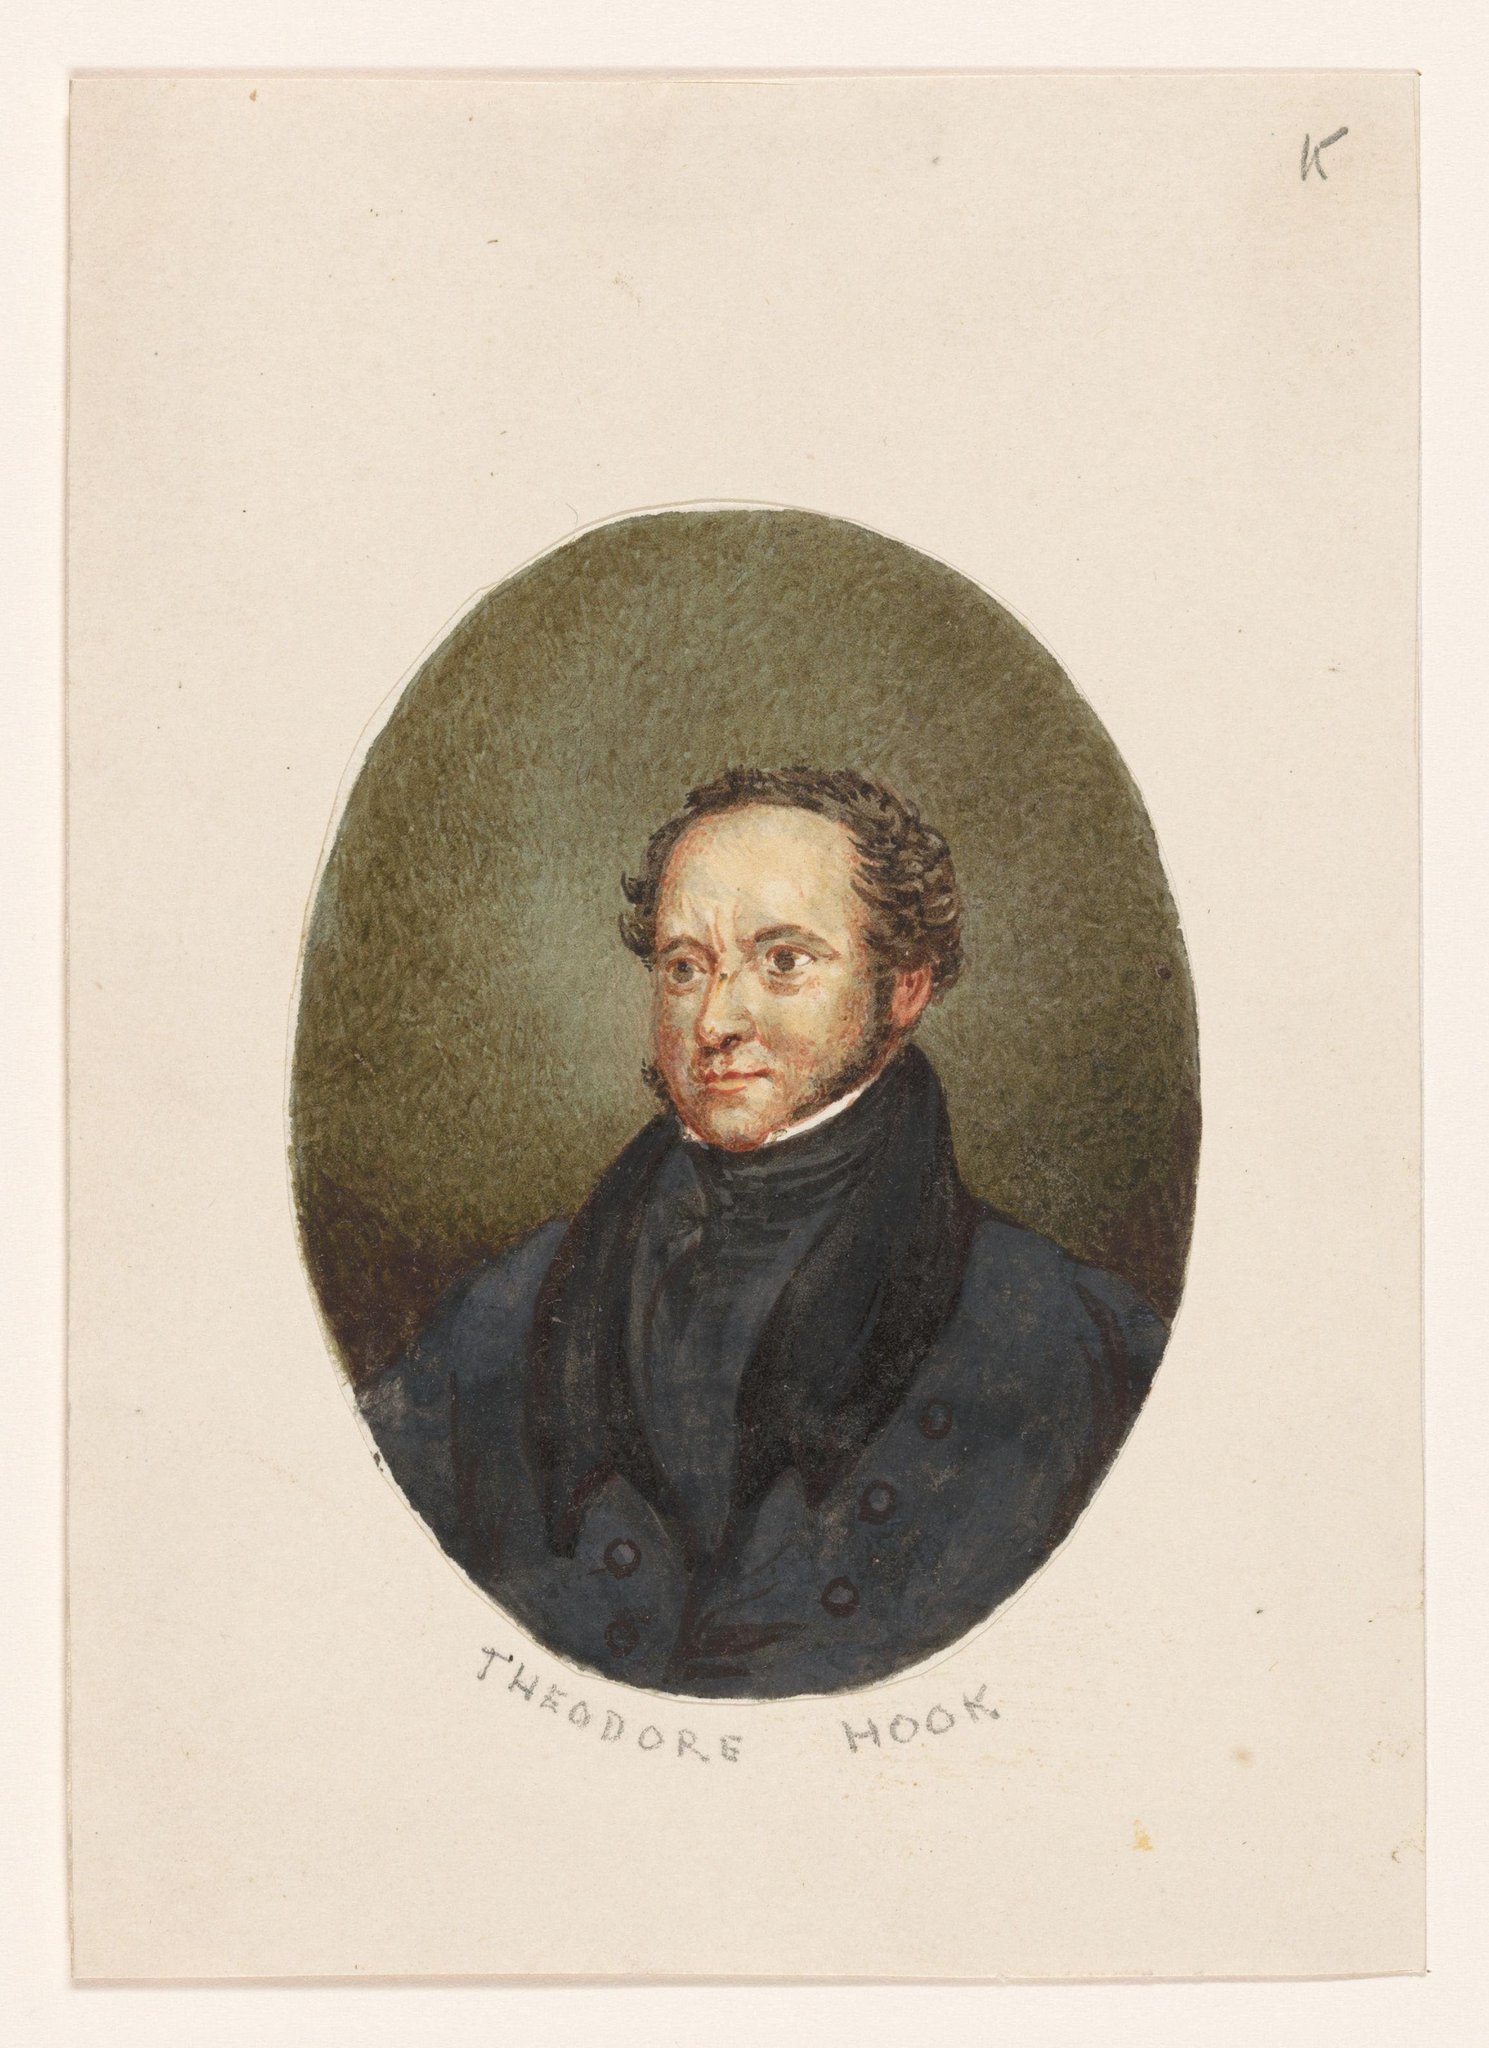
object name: drawing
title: Portret van schrijver Theodore Edward Hook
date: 1839-1899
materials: paper, watercolor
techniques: brush, snipping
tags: london, historical persons, writer, poet, author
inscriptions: collector's mark: Lugt 2228, annotation: ‘Theodore Hook’